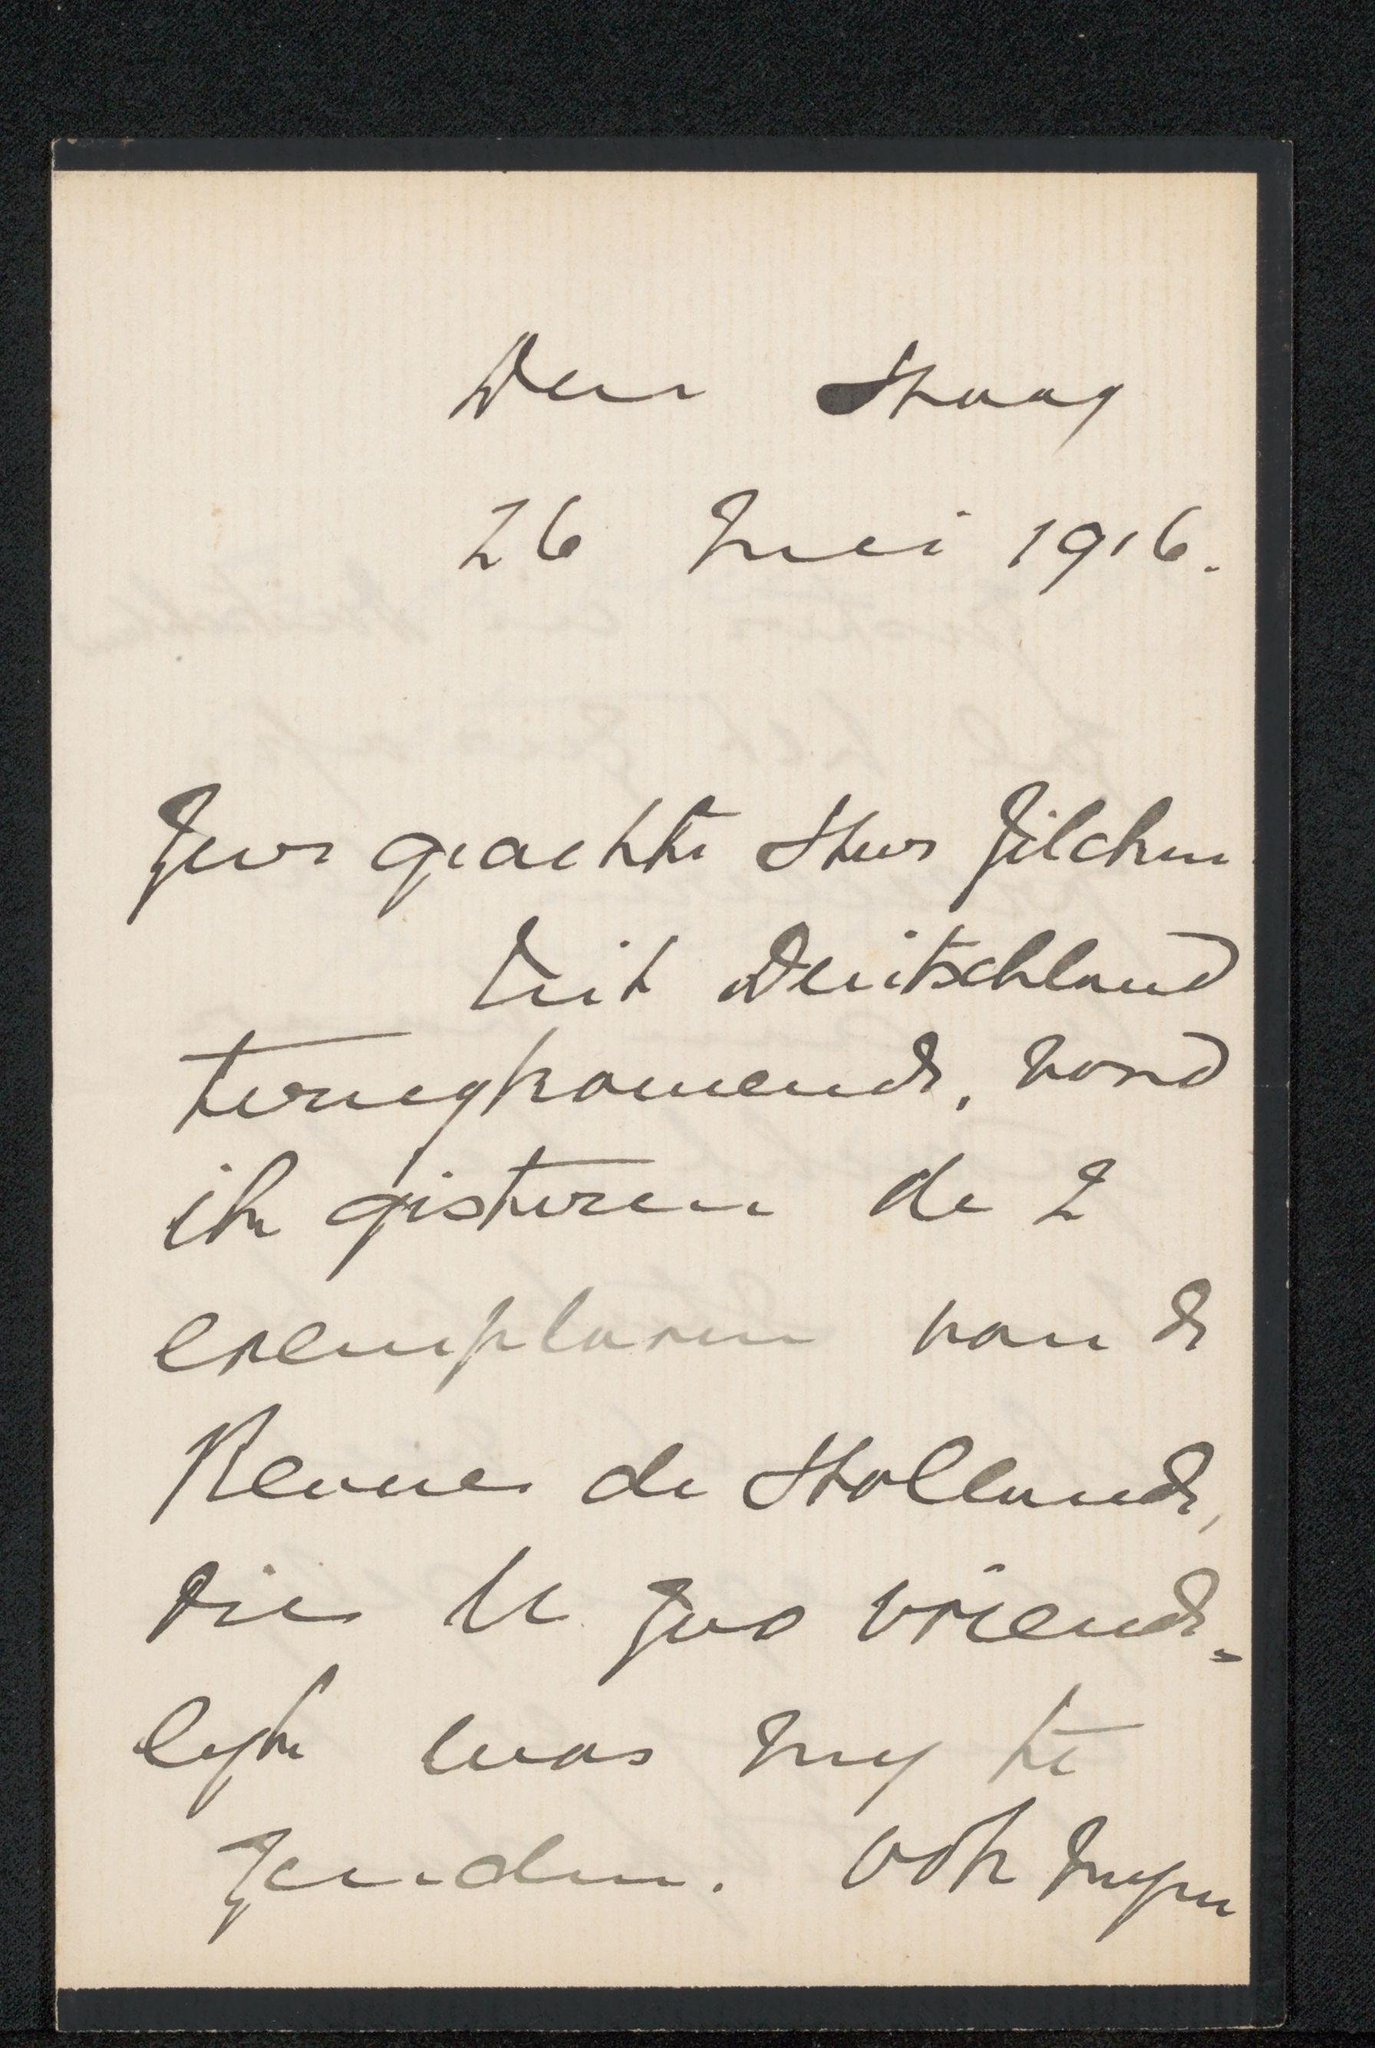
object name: letter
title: Brief aan Philip Zilcken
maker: eugénie loudon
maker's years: 1861-1940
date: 1916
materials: ink, paper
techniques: pen, writing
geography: the hague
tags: the hague, painter, draughtsman, philip zilcken, germany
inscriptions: collector's mark: ‘RPK’